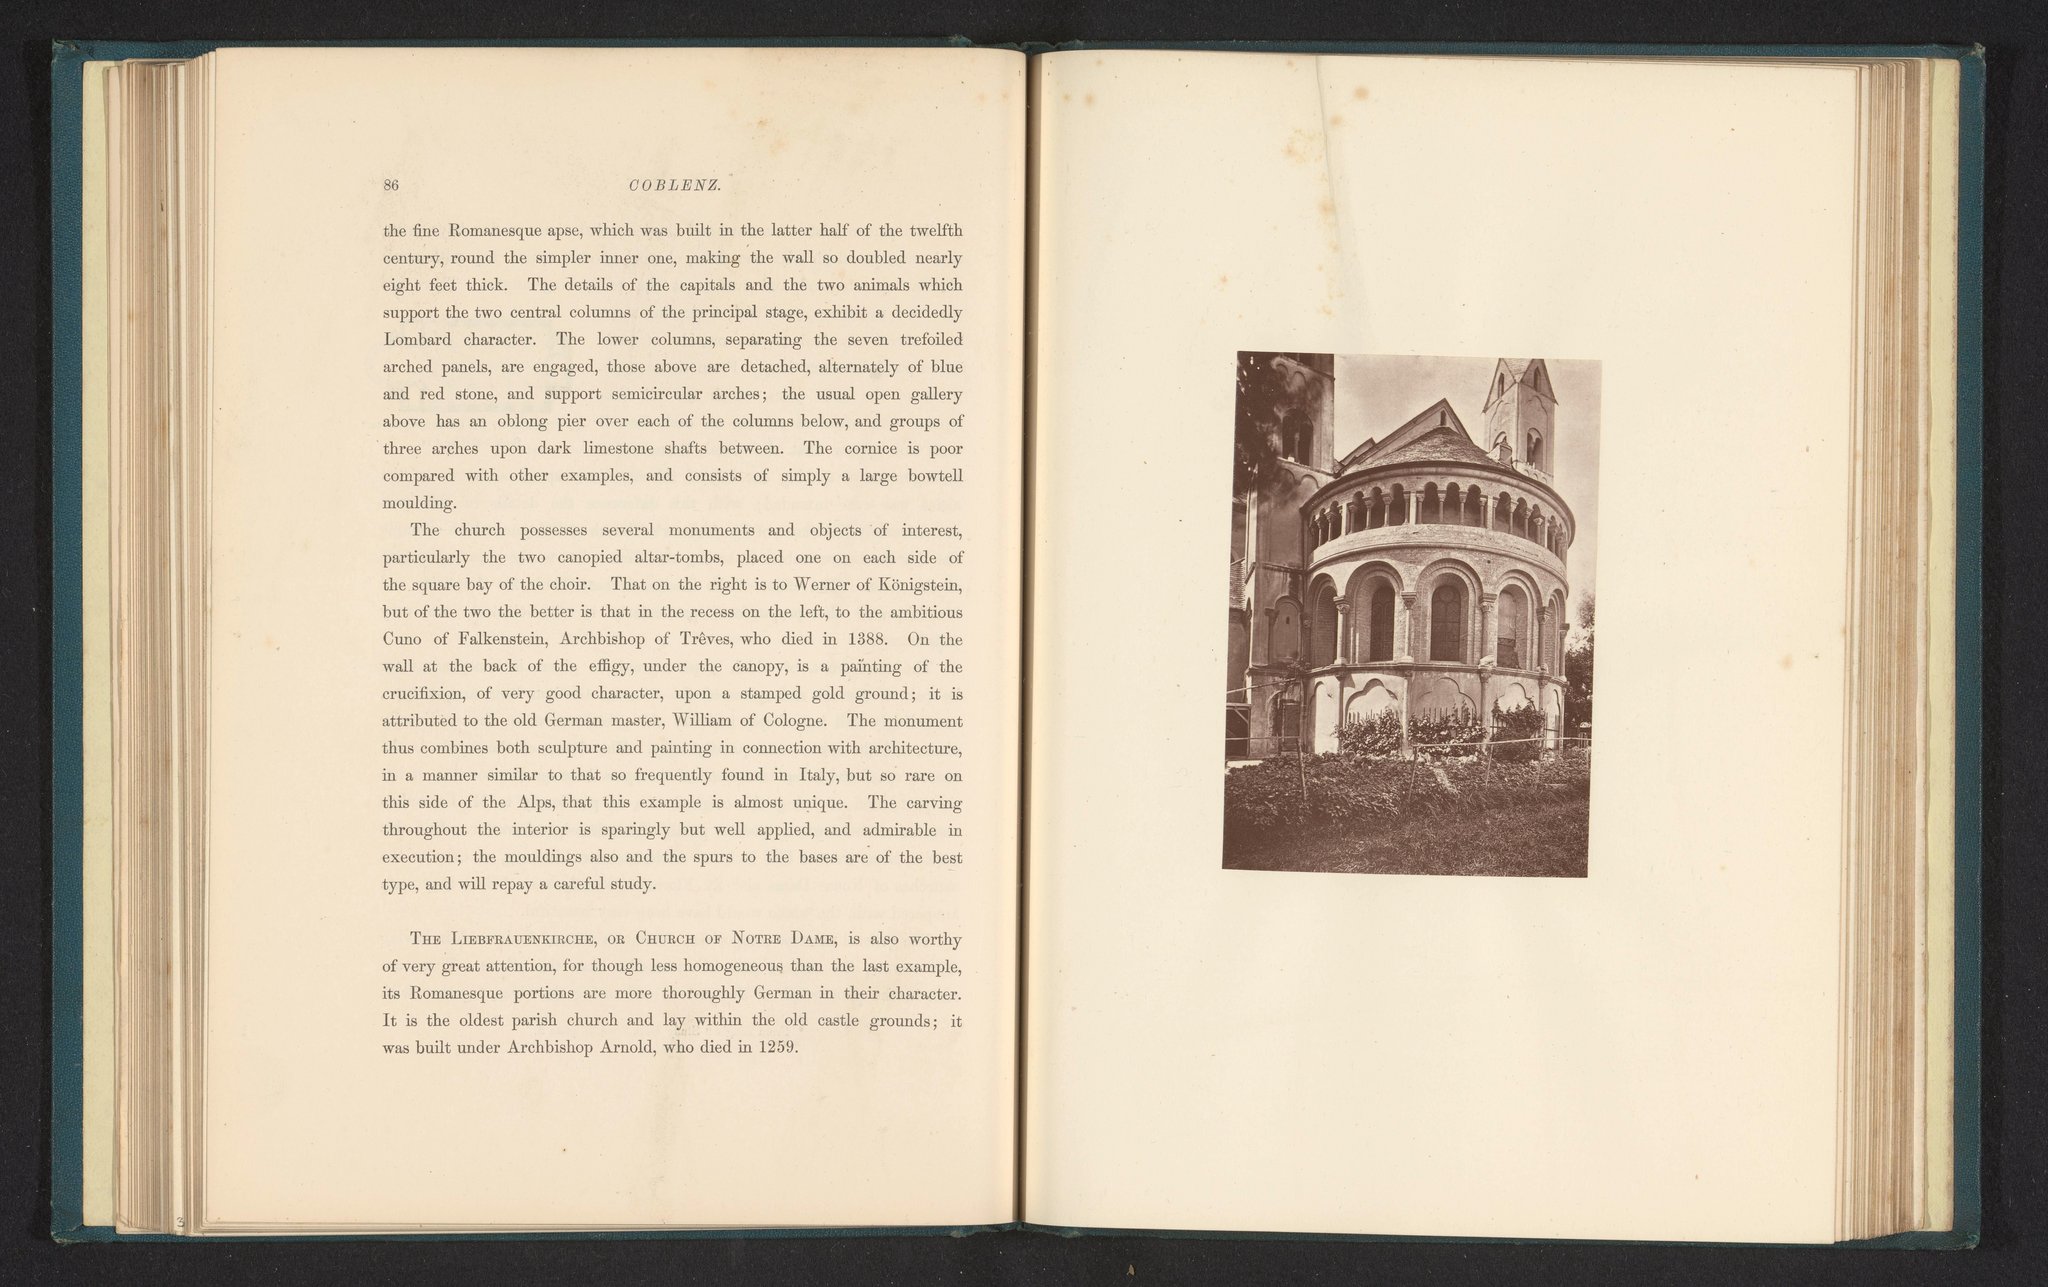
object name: page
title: Gezicht op het exterieur van het koor van de Sint-Kastorbasiliek in Koblenz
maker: Anonymous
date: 1858-1868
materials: paper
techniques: woodburytype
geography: koblenz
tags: parts of church exterior and annexes: choir, church (exterior)